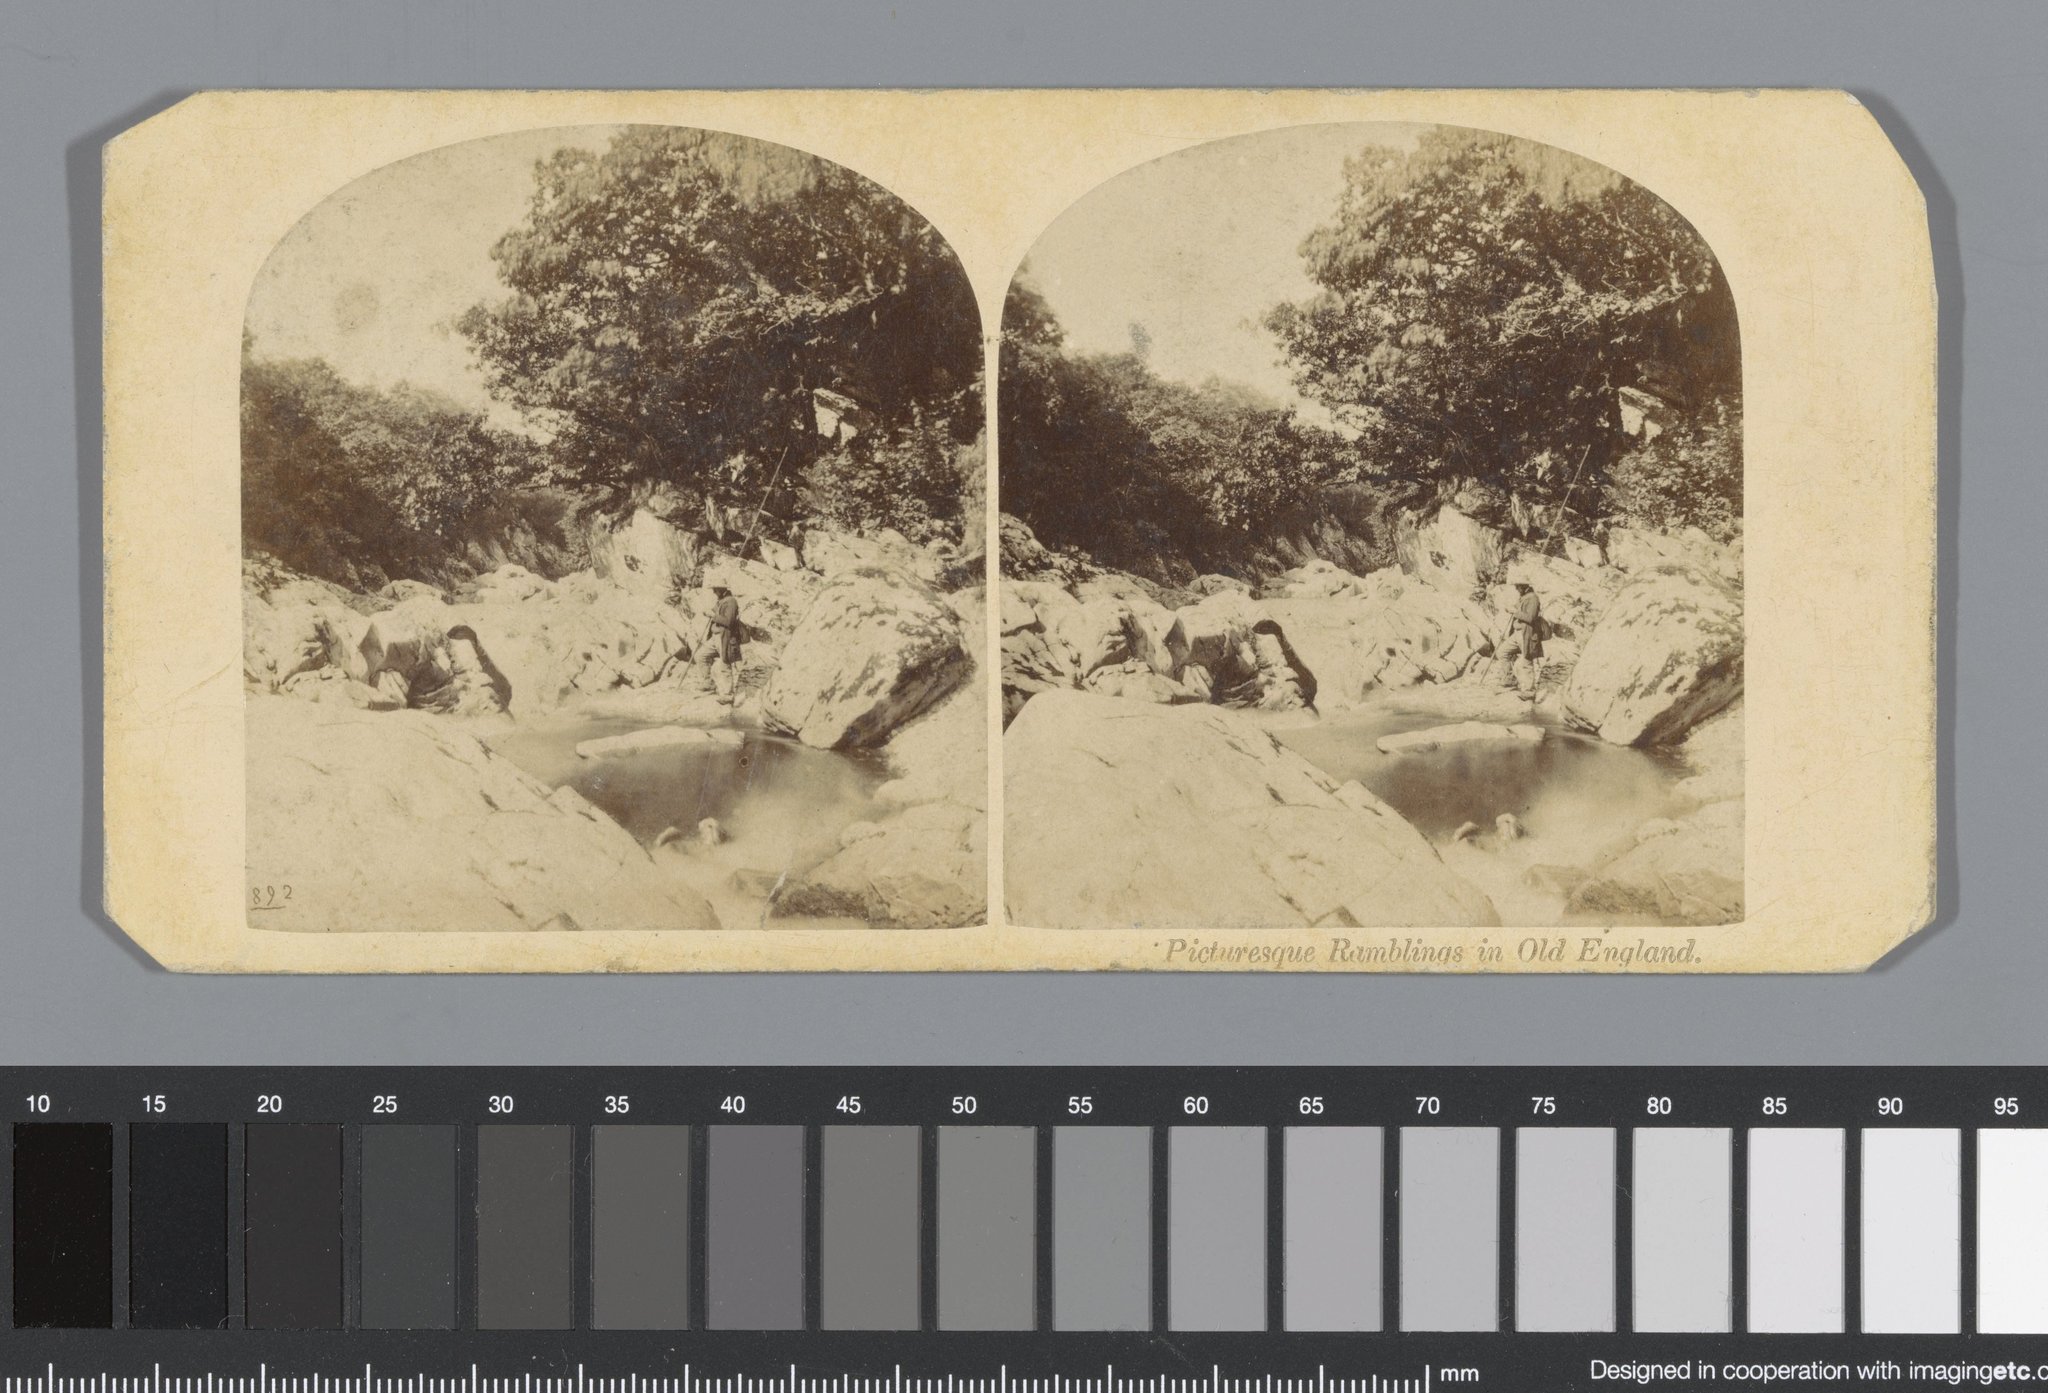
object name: stereograph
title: Picturesque Ramblings in Old England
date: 1854-1880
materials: cardboard, photographic support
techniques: albumen print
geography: england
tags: river, fisherman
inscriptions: number: ‘892’, number: ‘54’